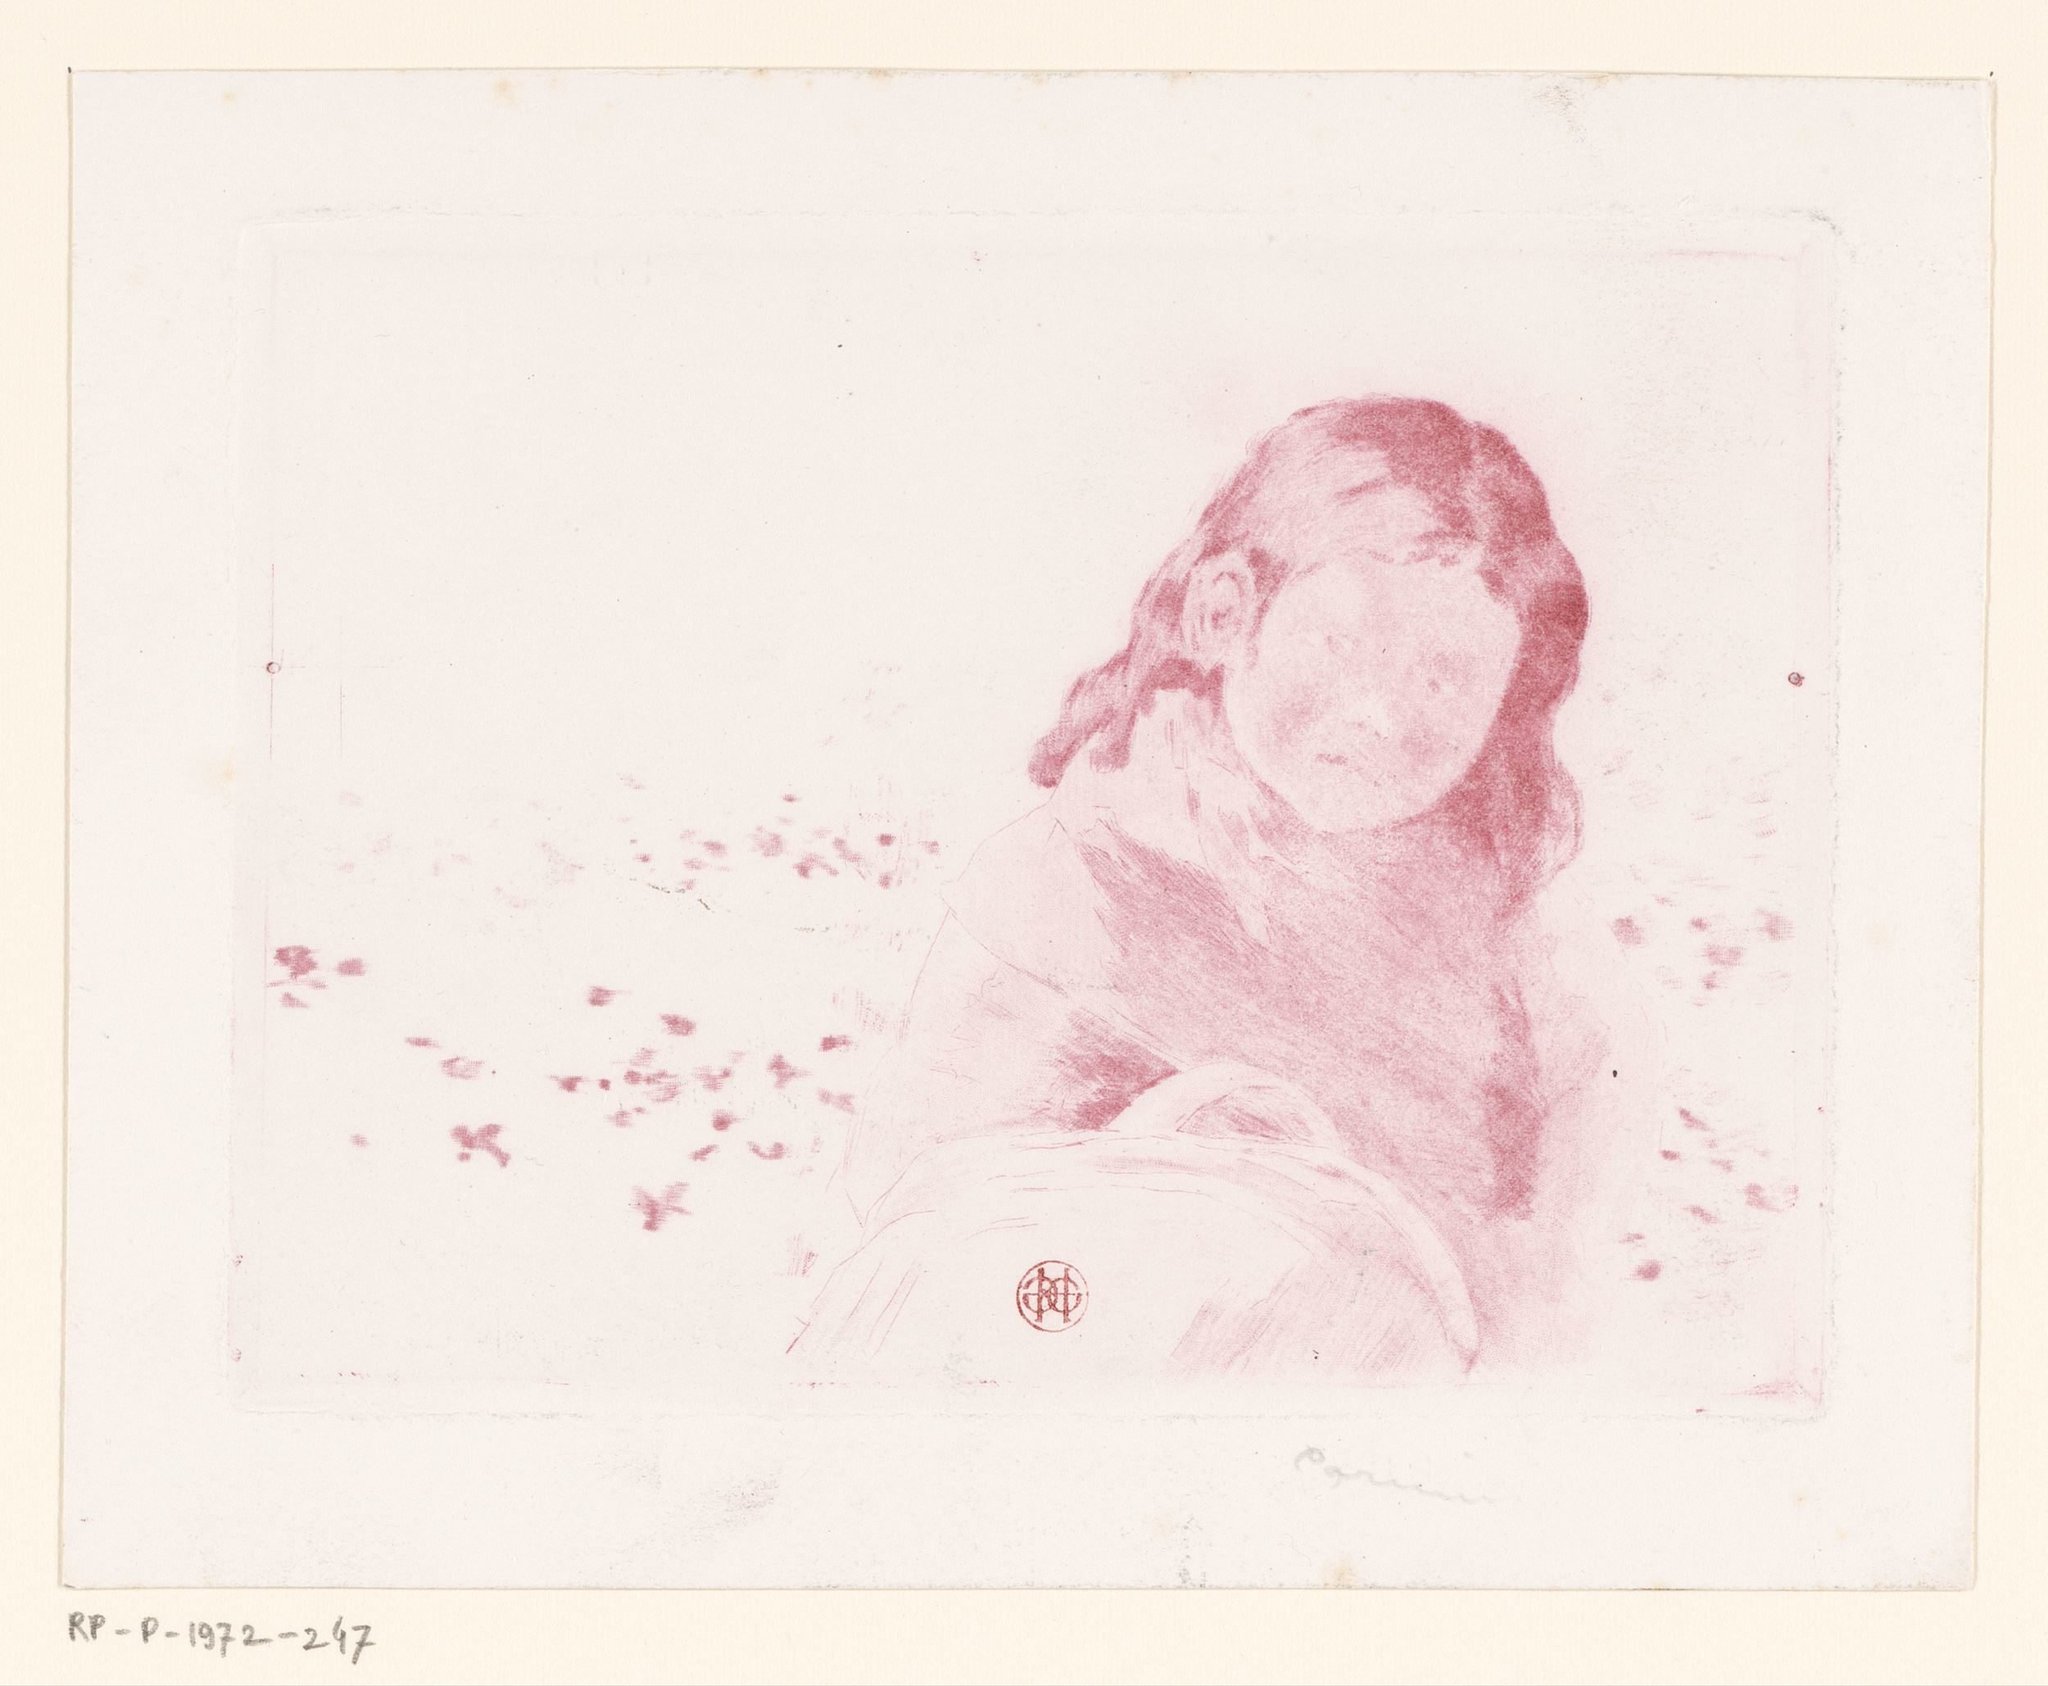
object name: print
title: Meisje met mand in een bloemenweide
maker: henri charles guérard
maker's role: print maker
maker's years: 1846-1897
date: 1856-1897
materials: paper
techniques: roulette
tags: meadow, pasture, container made of plant material other than wood: basket, girl (child between toddler and youth)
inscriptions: collector's mark: Lugt 2228, stamp: Lugt 1157, collector's mark: Lugt 2760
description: Het Rijksmuseum beschikt over negentien drukken van dezelfde voorstelling (RP-P-1972-234 t/m RP-P-1972-252) in verschillende staten en tonen.